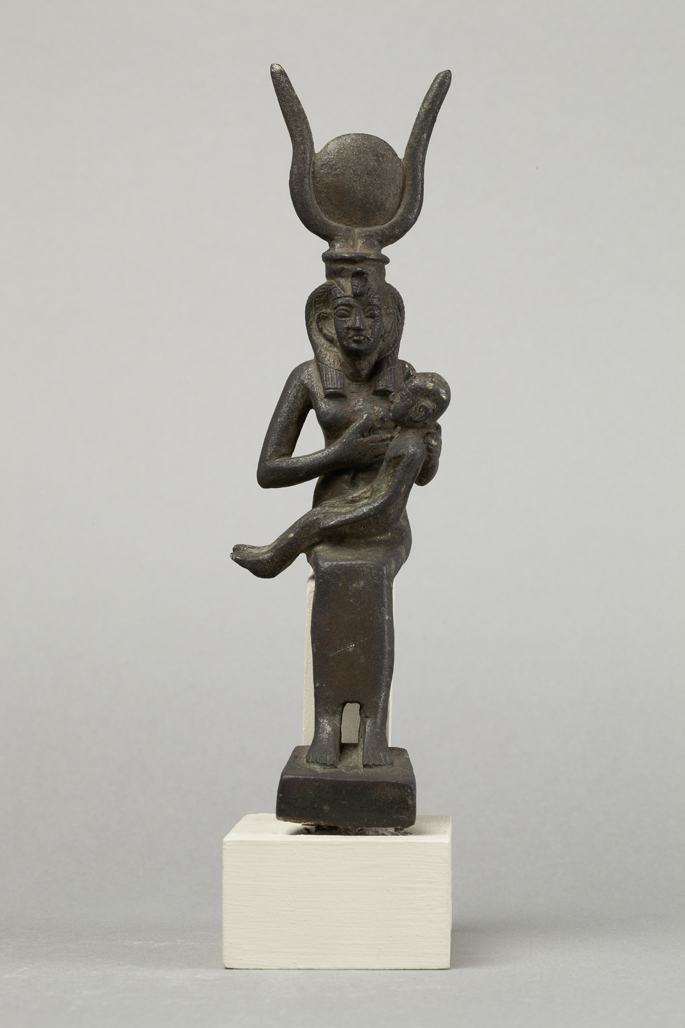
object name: statuette, isi, horus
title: Isis and Horus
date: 664-630 BCE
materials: metal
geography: egypt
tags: horus,isis,nursing